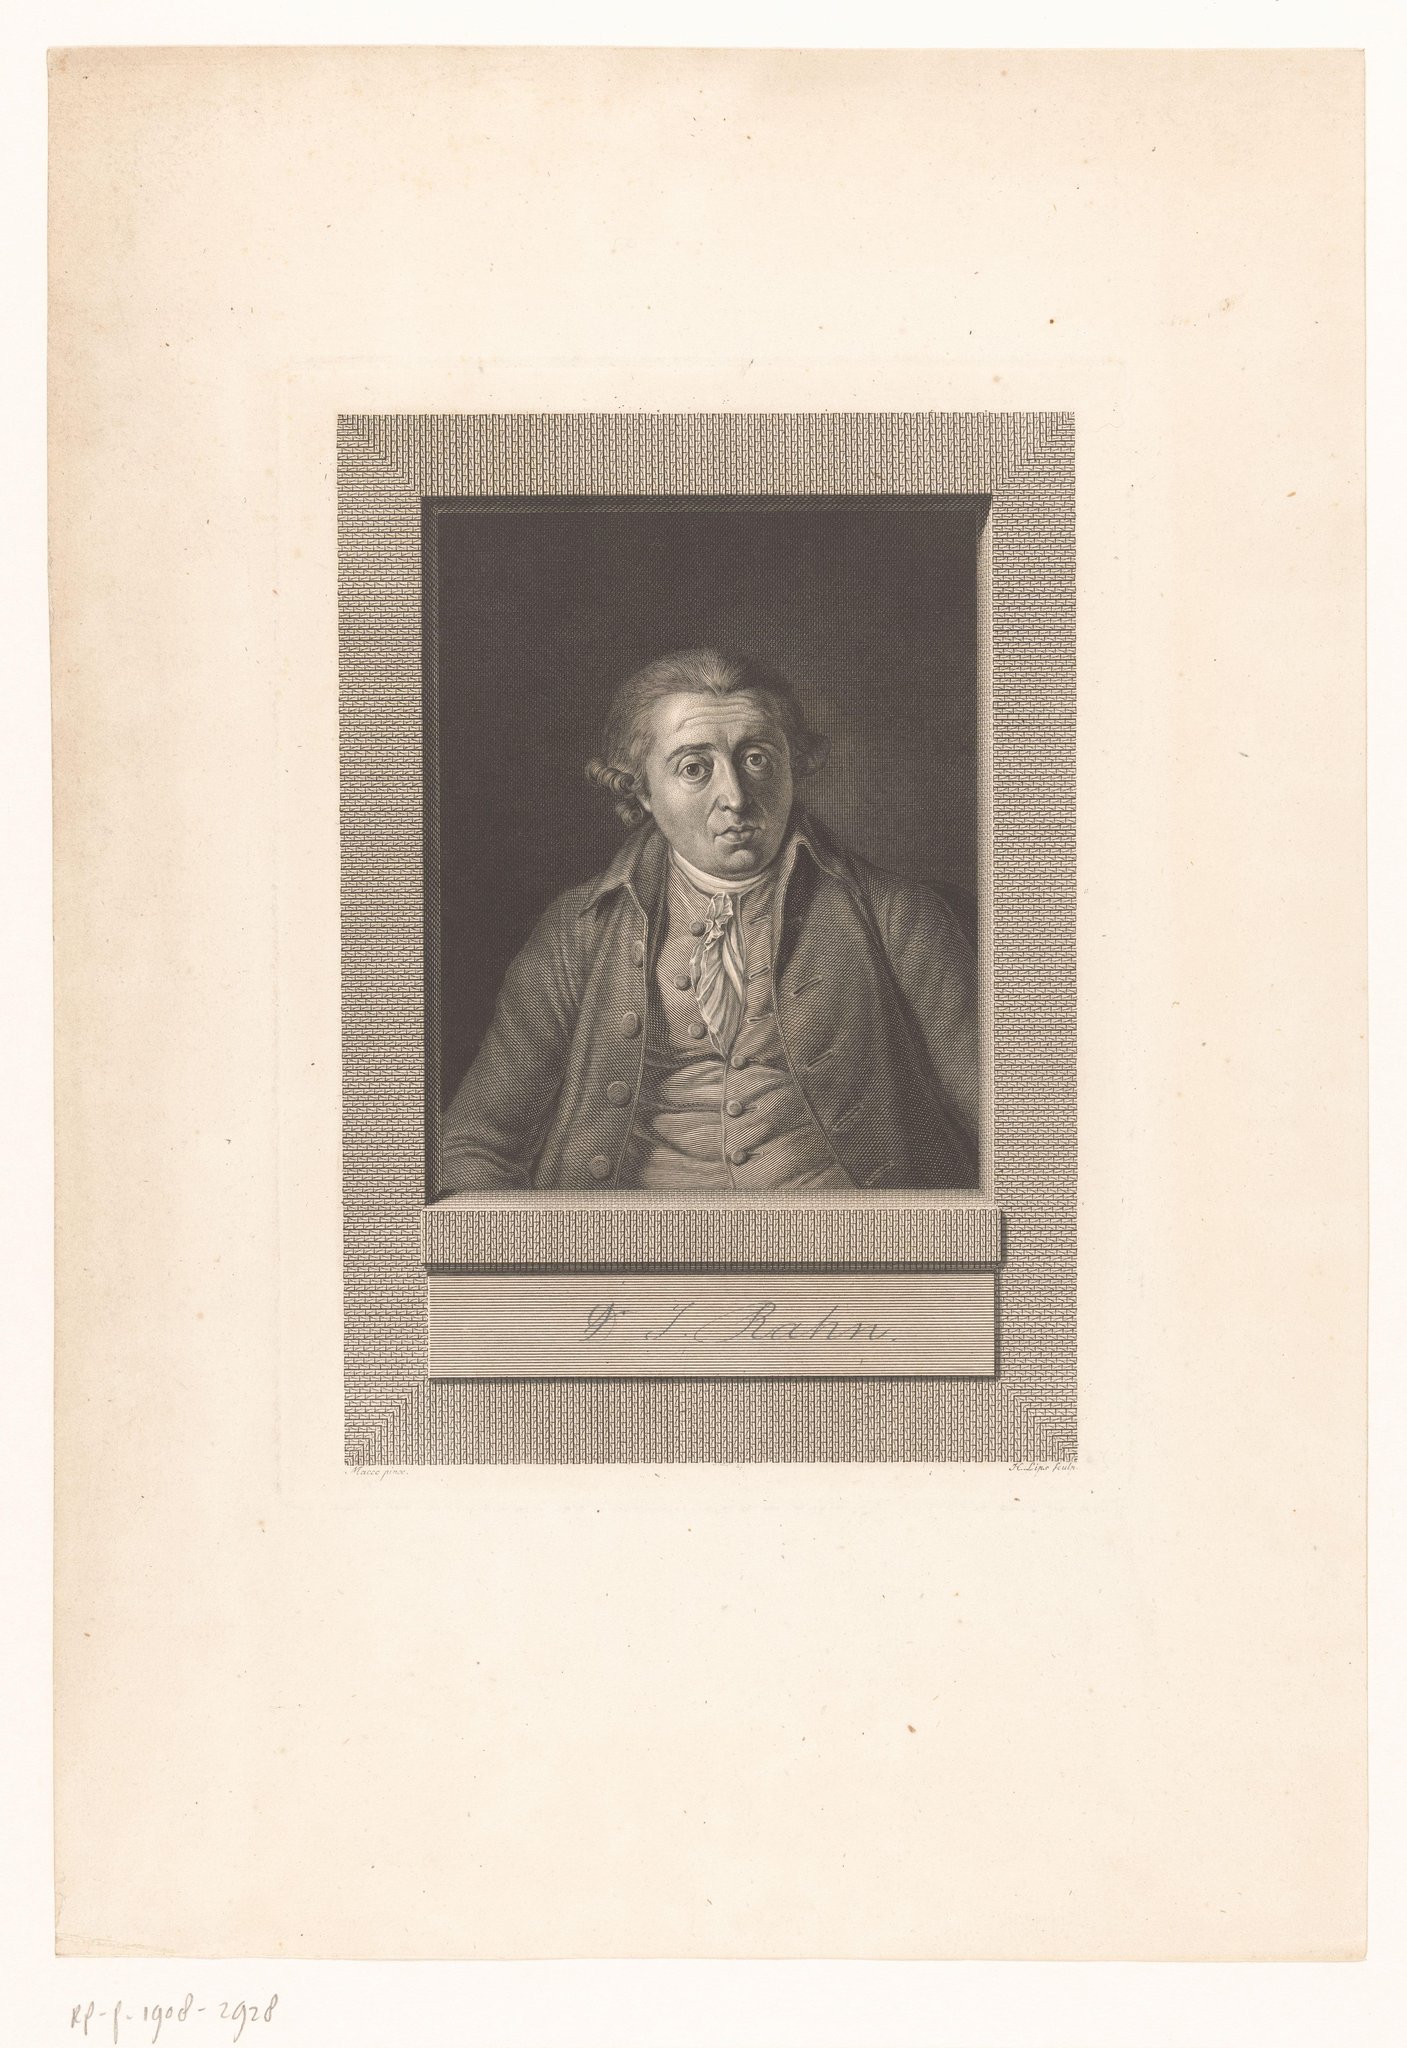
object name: print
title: Portret van Johann Heinrich Rahn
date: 1768-1817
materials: paper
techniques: engraving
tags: historical persons, physician, doctor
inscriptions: name, collector's mark: Lugt 2228